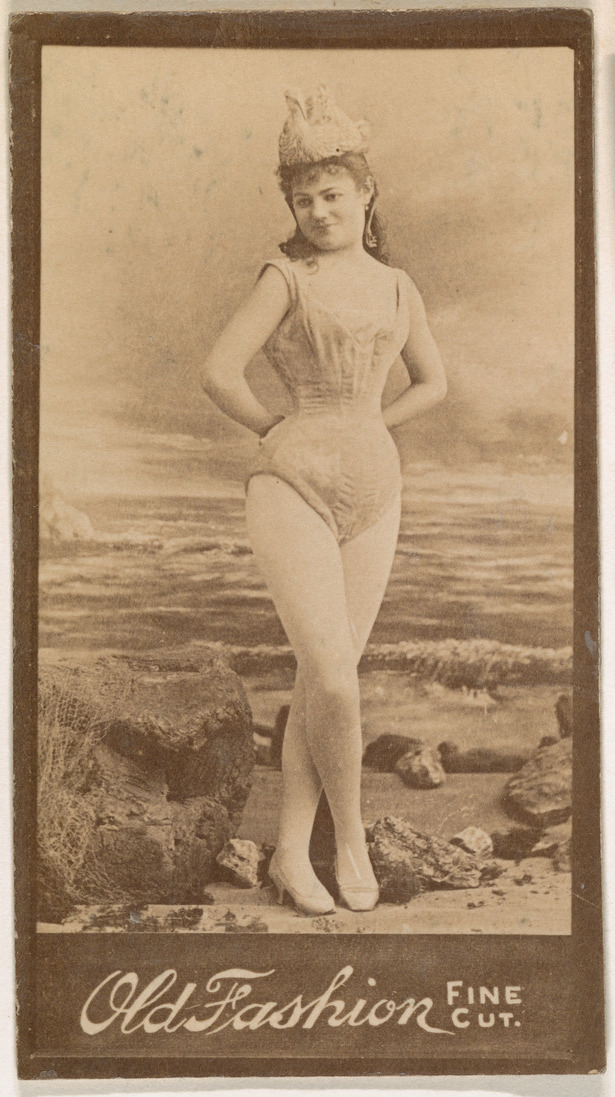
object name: photograph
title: Actress in studio seaside scene, from the Actresses series (N664) promoting Old Fashion Fine Cut Tobacco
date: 1888-1890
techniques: albumen silver print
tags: portraits,women,actresses